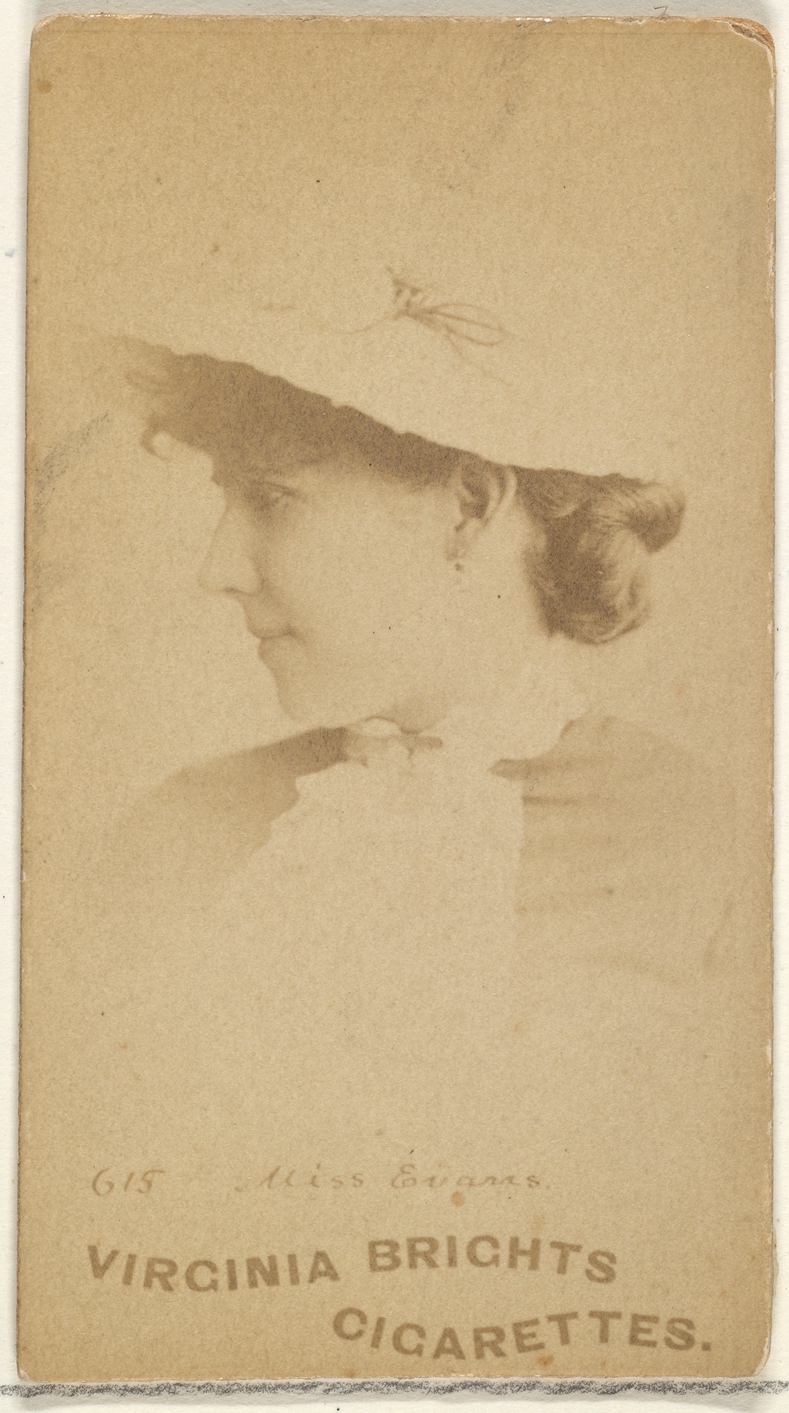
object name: photograph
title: Card 615, Miss Evans, from the Actors and Actresses series (N45, Type 1) for Virginia Brights Cigarettes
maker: allen & ginter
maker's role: publisher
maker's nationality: american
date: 1888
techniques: albumen silver print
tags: portraits,profiles,women,actresses